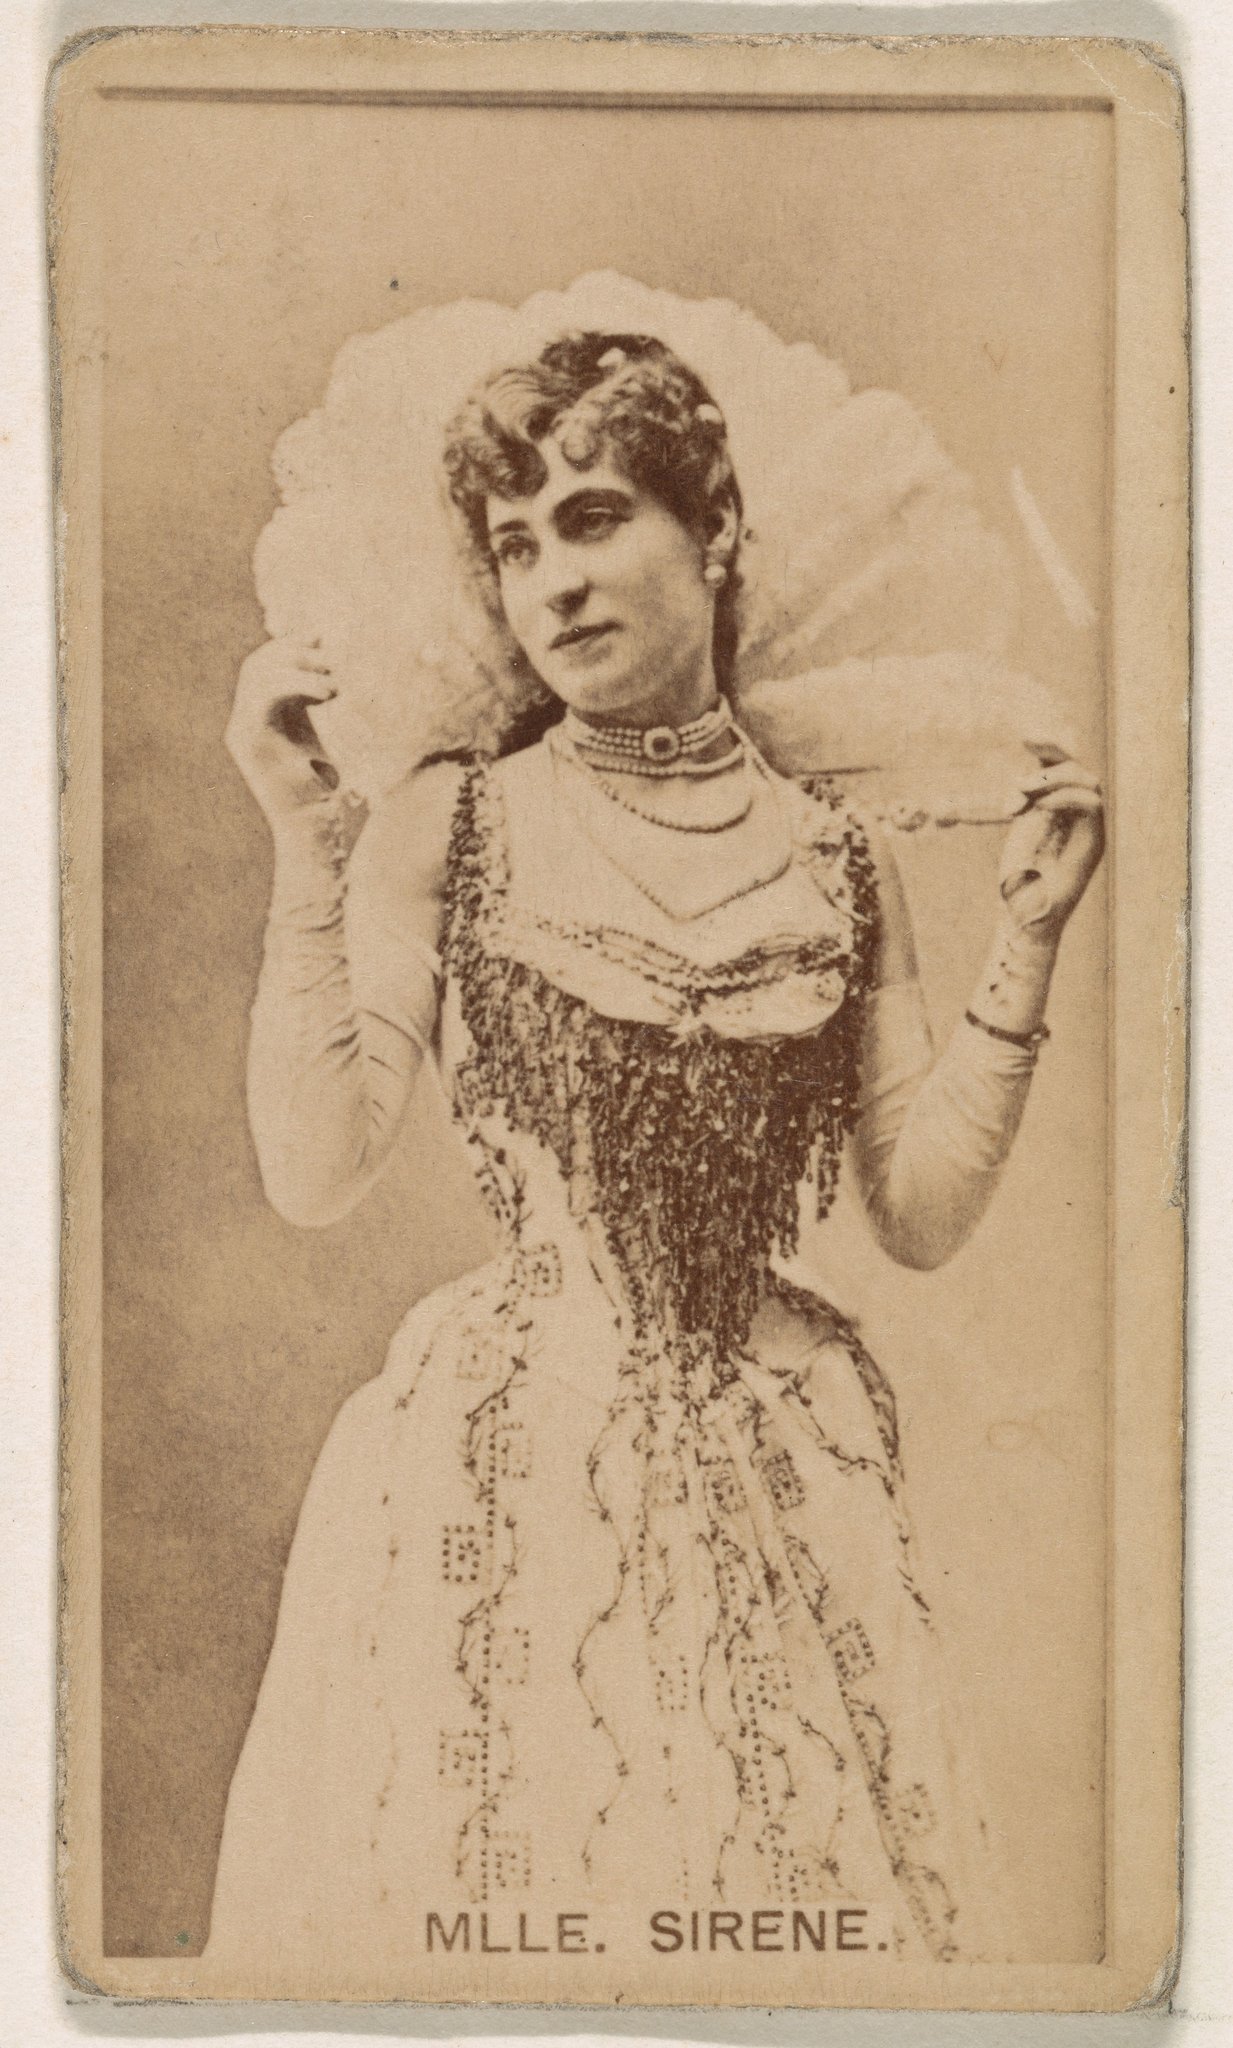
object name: photograph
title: Mlle. Sirene, from the Actresses series (N245) issued by Kinney Brothers to promote Sweet Caporal Cigarettes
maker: kinney brothers tobacco company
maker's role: publisher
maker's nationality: american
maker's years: 1869-2011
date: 1890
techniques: albumen silver print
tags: portraits,women,actresses